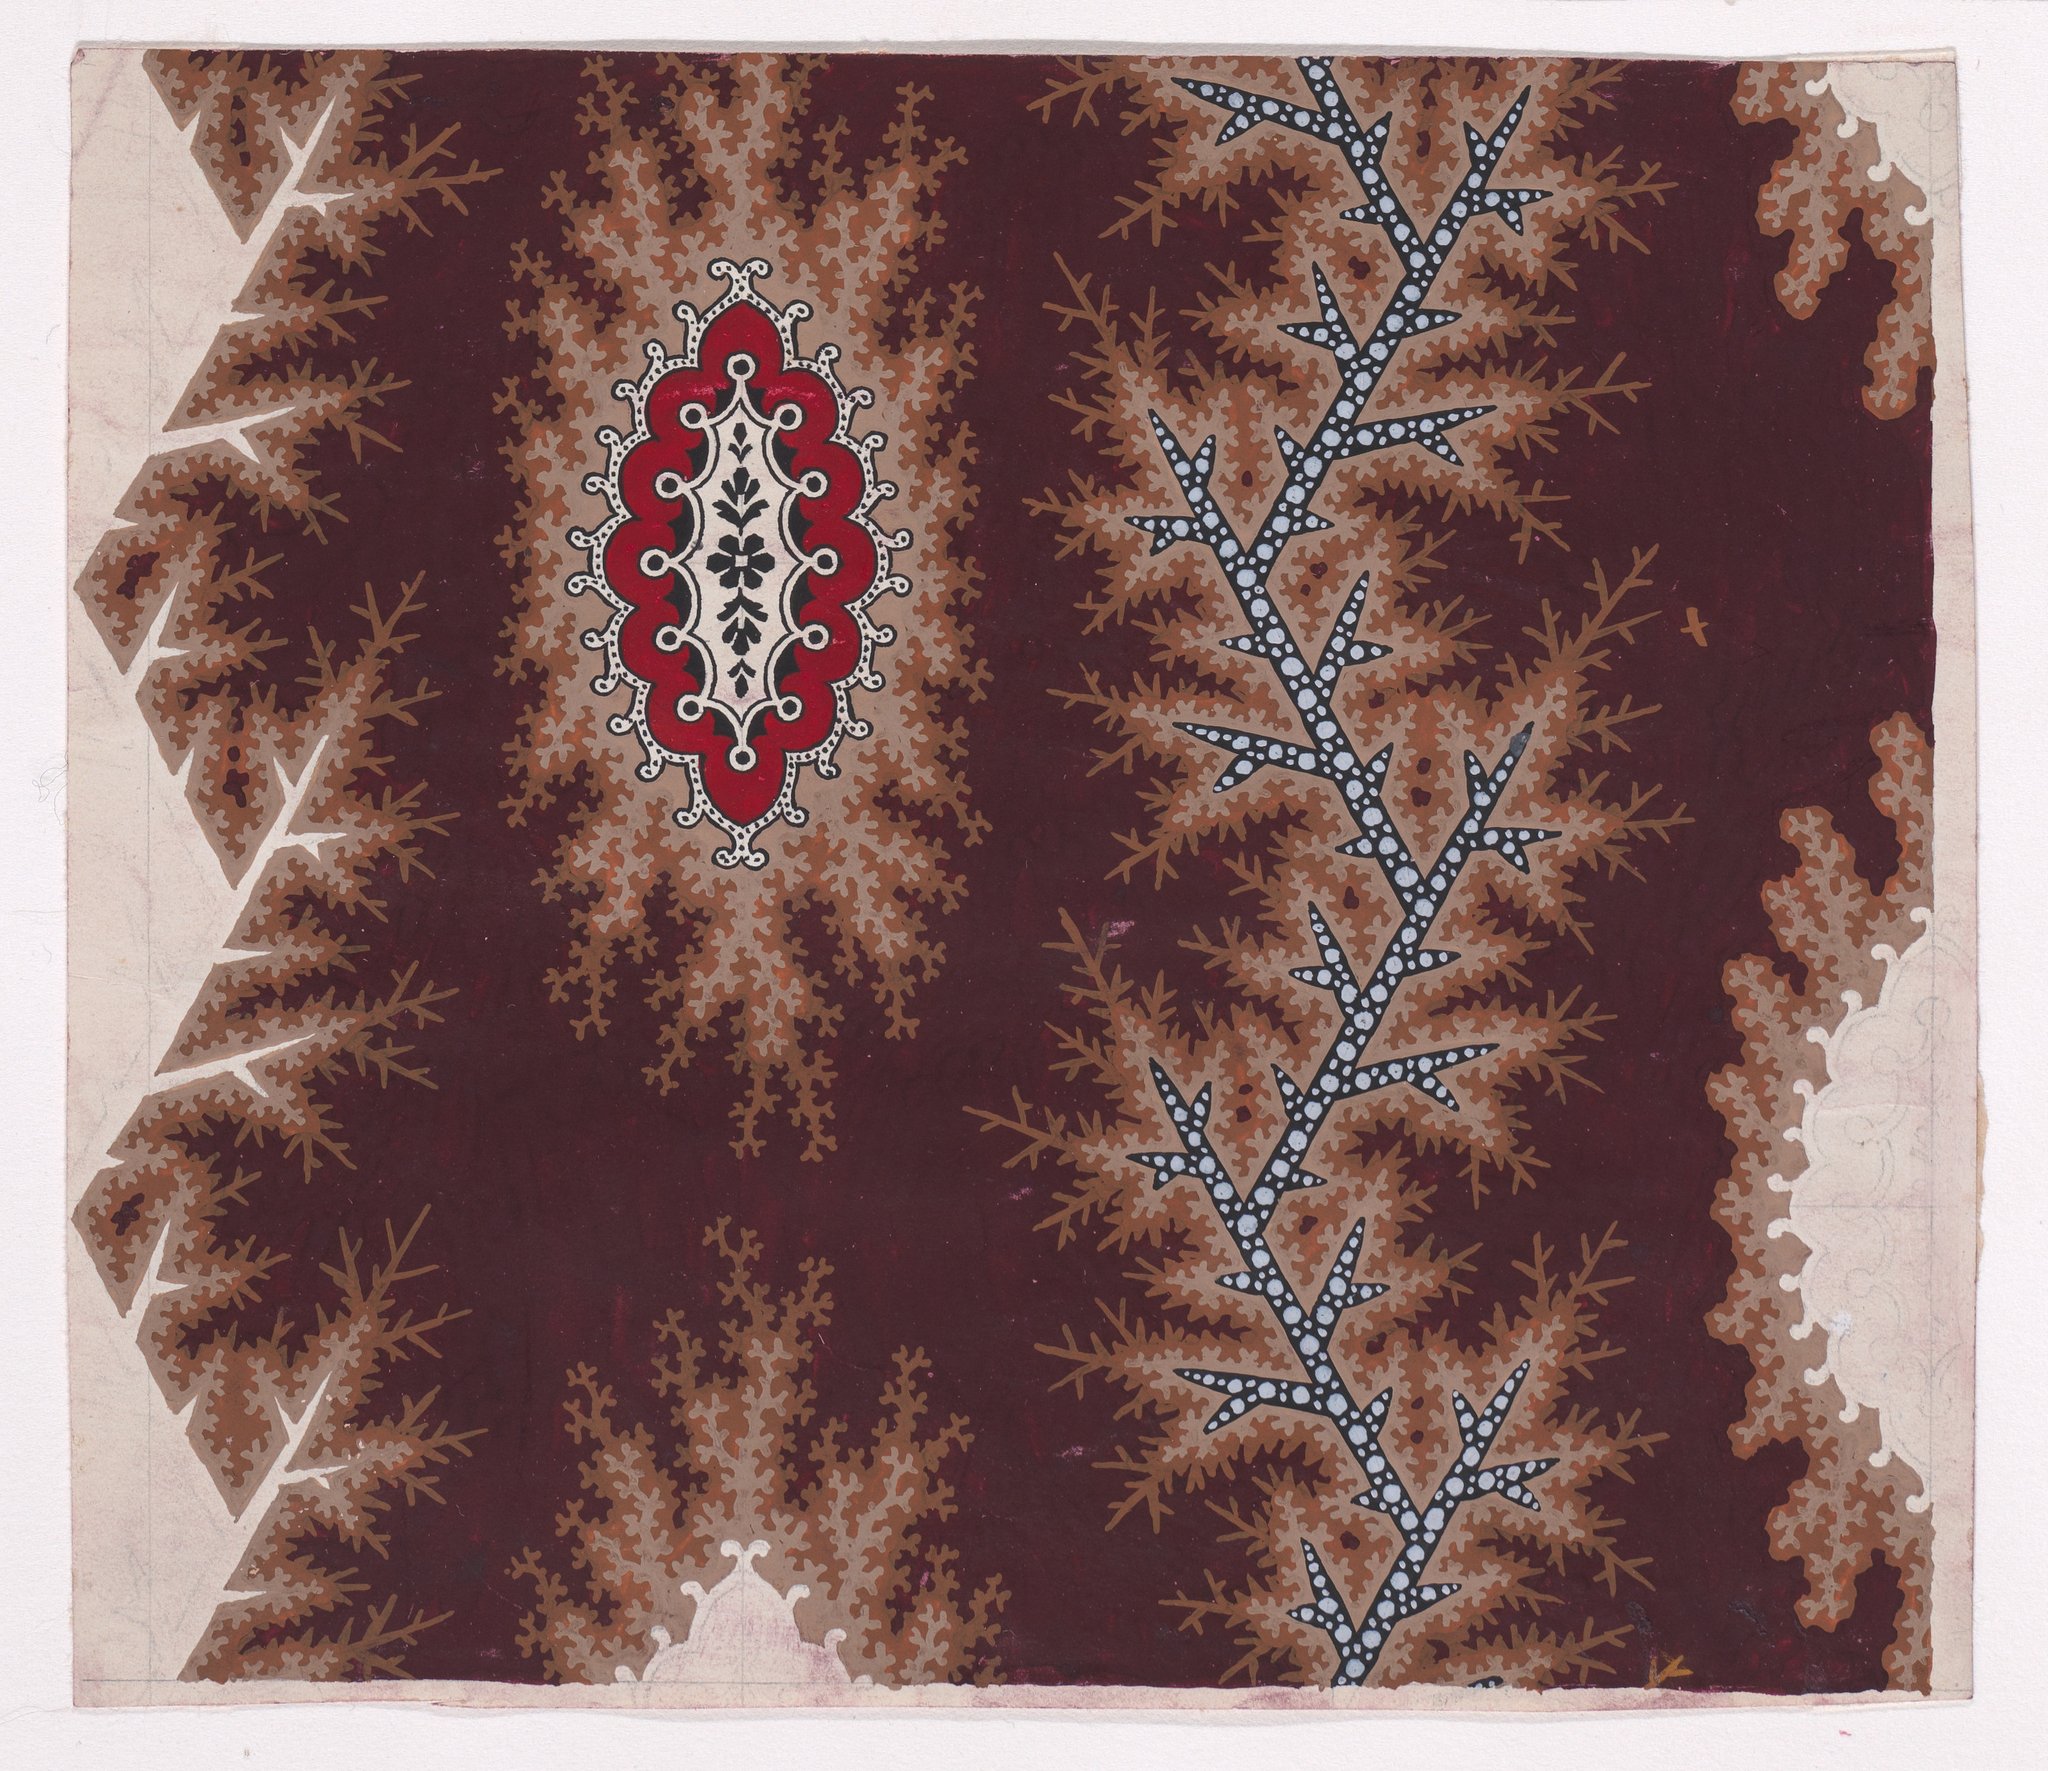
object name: drawing ornament architecture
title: Textile Design with Alternating Vertical Strips of Stiff Branches and Rosettes with Flanks over Ornamental Frames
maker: anonymous, alsatian, 19th century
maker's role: artist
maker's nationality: alsatian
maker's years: 1800-1900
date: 1840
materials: gouache